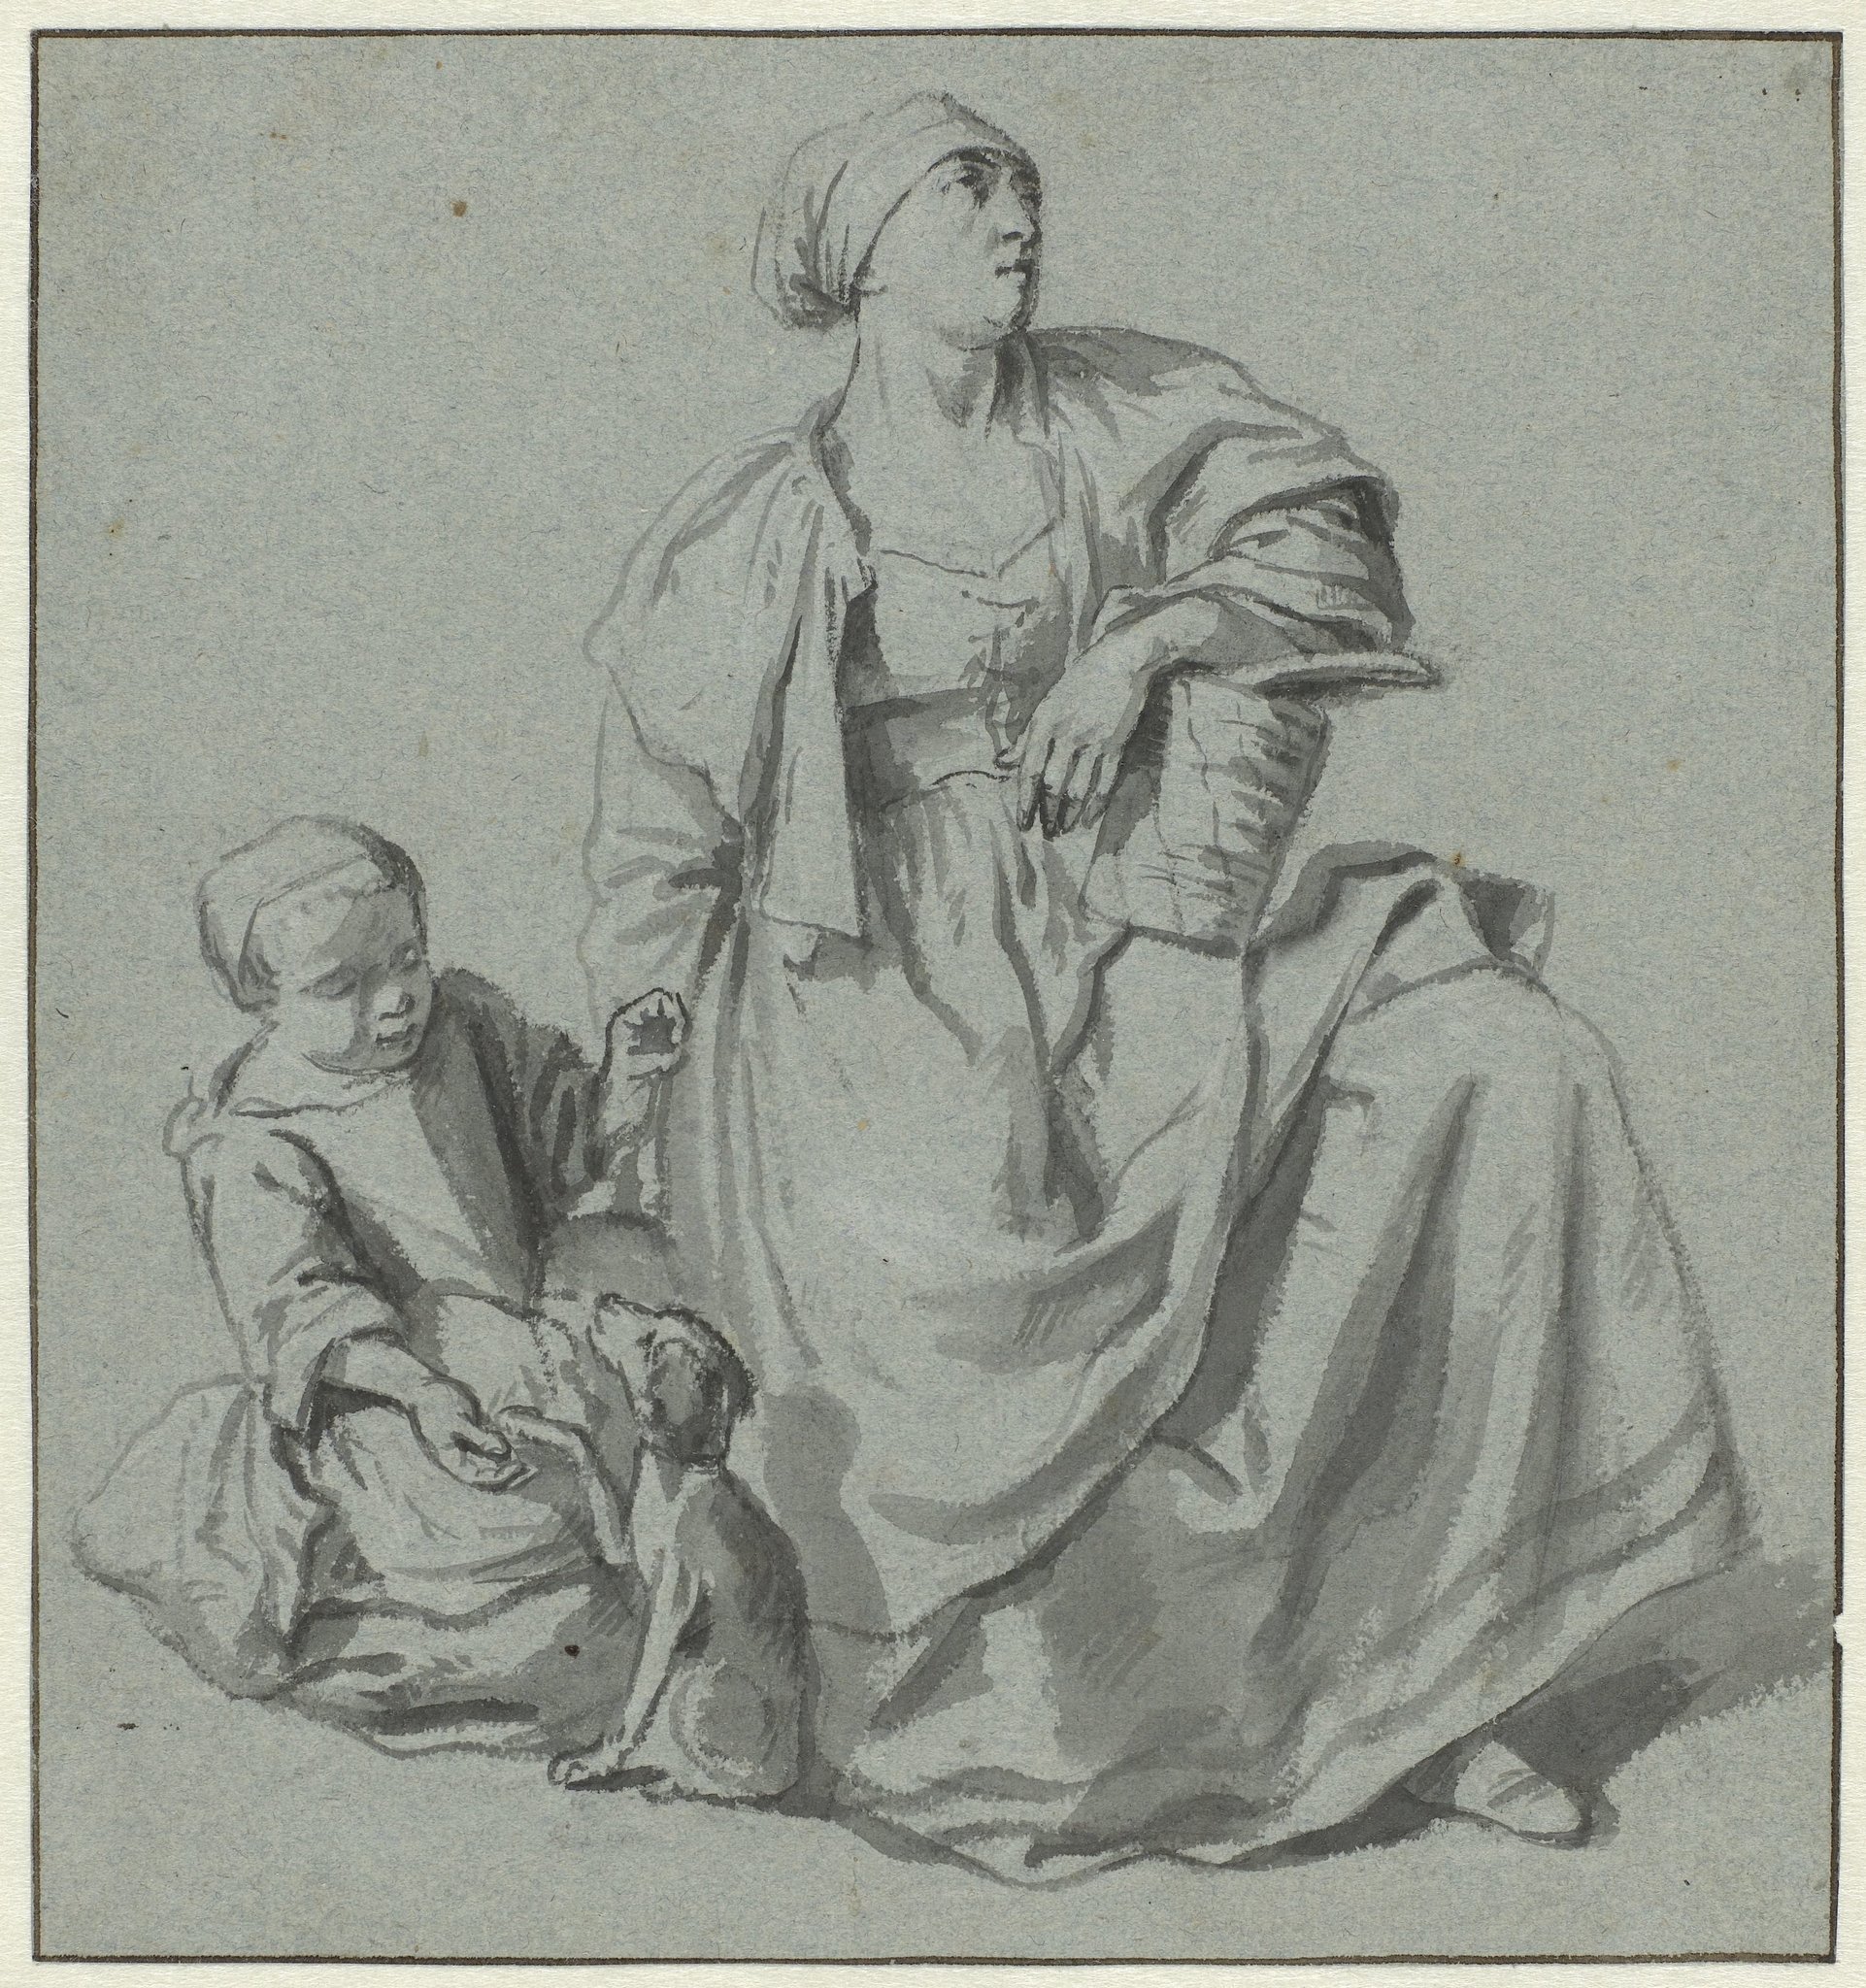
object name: drawing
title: Zittende vrouw, een meisje en een hond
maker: cornelis pietersz. bega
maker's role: draughtsman, painter, print maker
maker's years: 1631-1664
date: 1641-1664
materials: paper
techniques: brush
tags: dog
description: Een zittende vrouw die omhoog kijkt en een meisje dat op de grond zit en met een hond speelt.